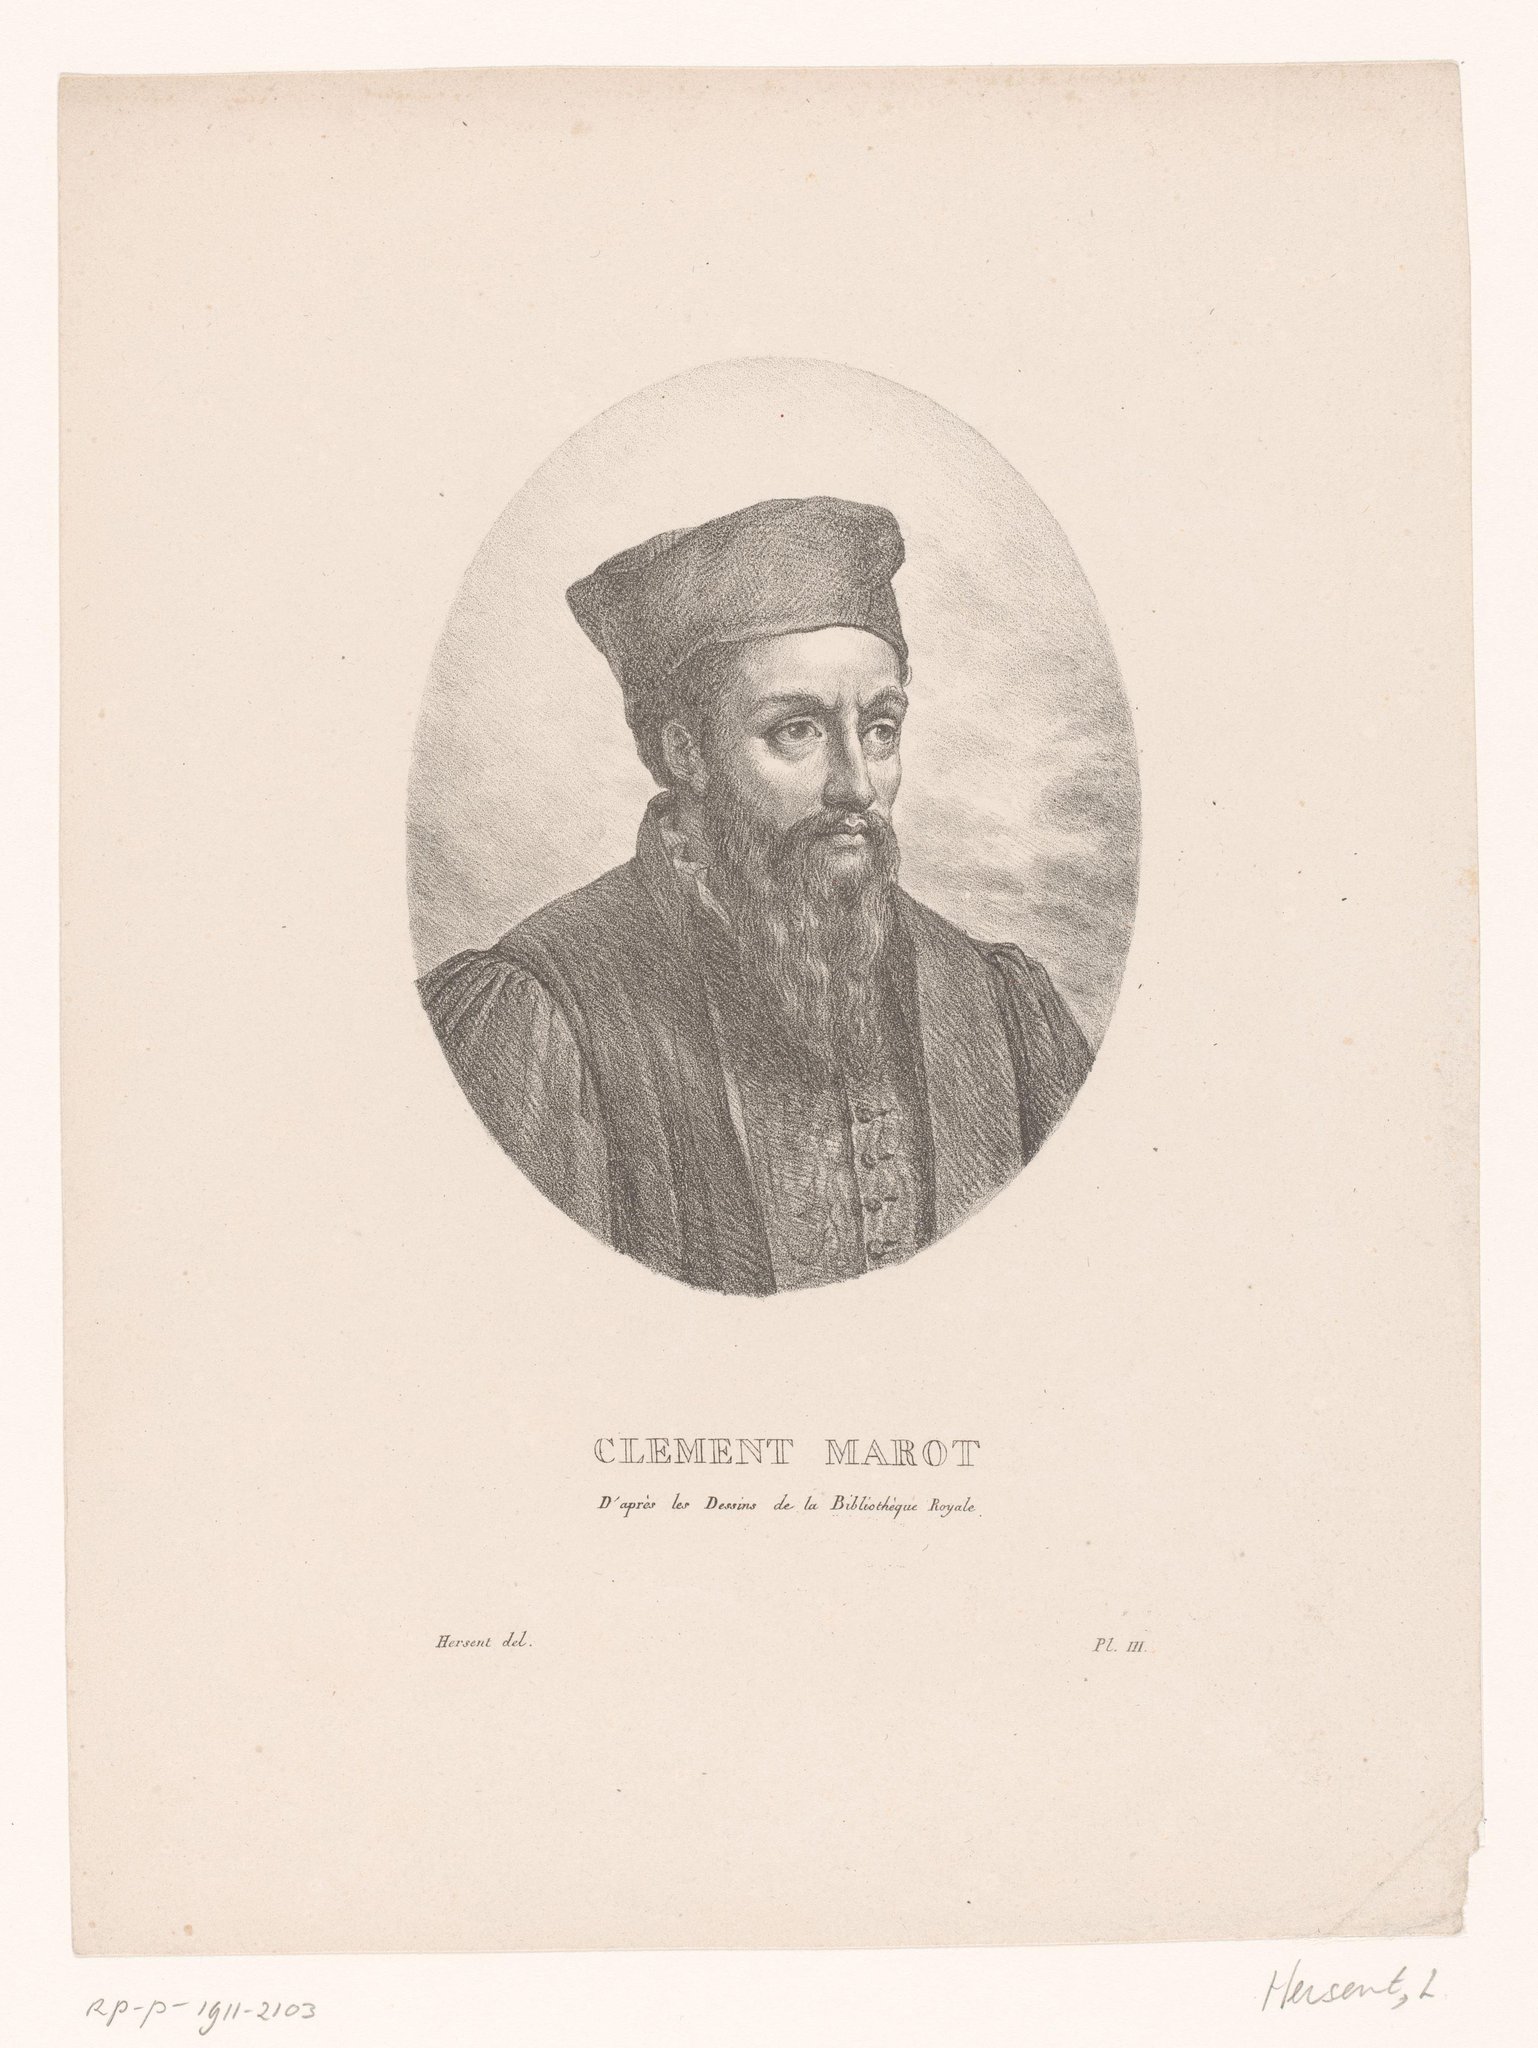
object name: print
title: Portret van Clément Marot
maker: louis hersent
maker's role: painter, print maker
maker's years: 1777-1860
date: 1813-1841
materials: paper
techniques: lithograph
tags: historical persons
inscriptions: collector's mark: Lugt 2228a